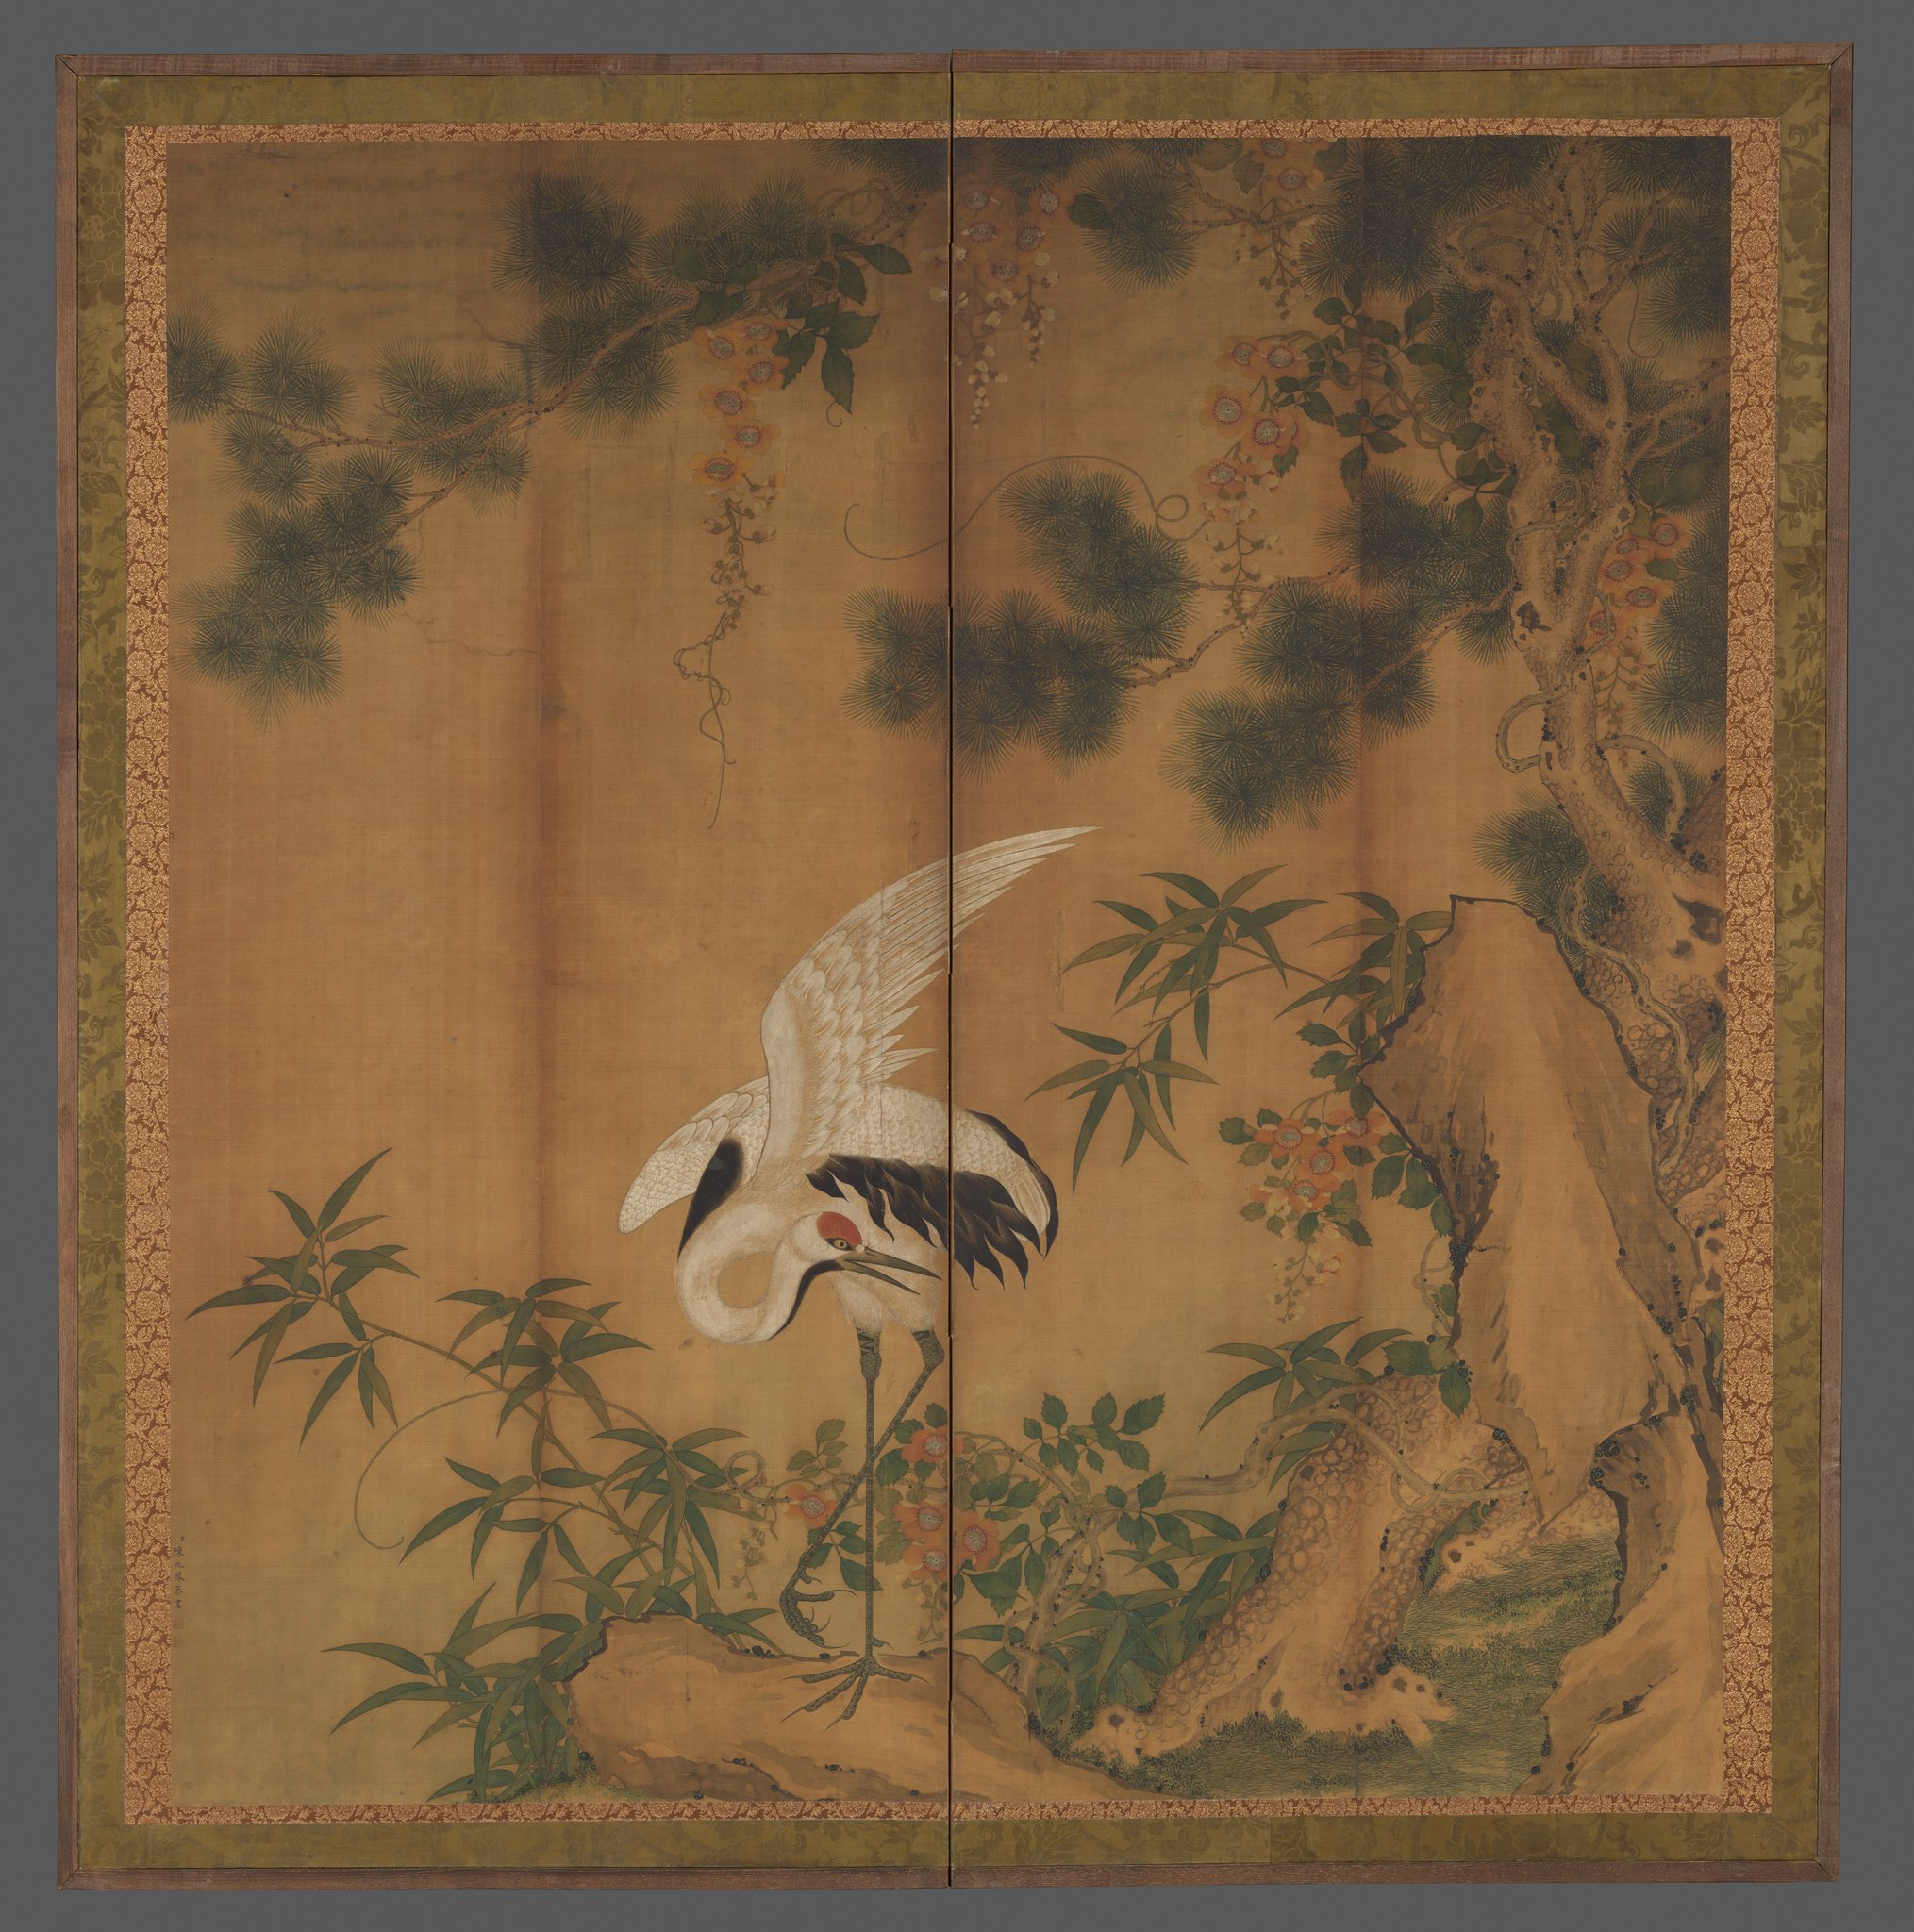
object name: screen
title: Crane, pine, and rock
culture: chinese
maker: chen zhaofeng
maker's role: artist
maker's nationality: chinese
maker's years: 1867-1899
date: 1867-1900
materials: ink, silk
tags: cranes,trees